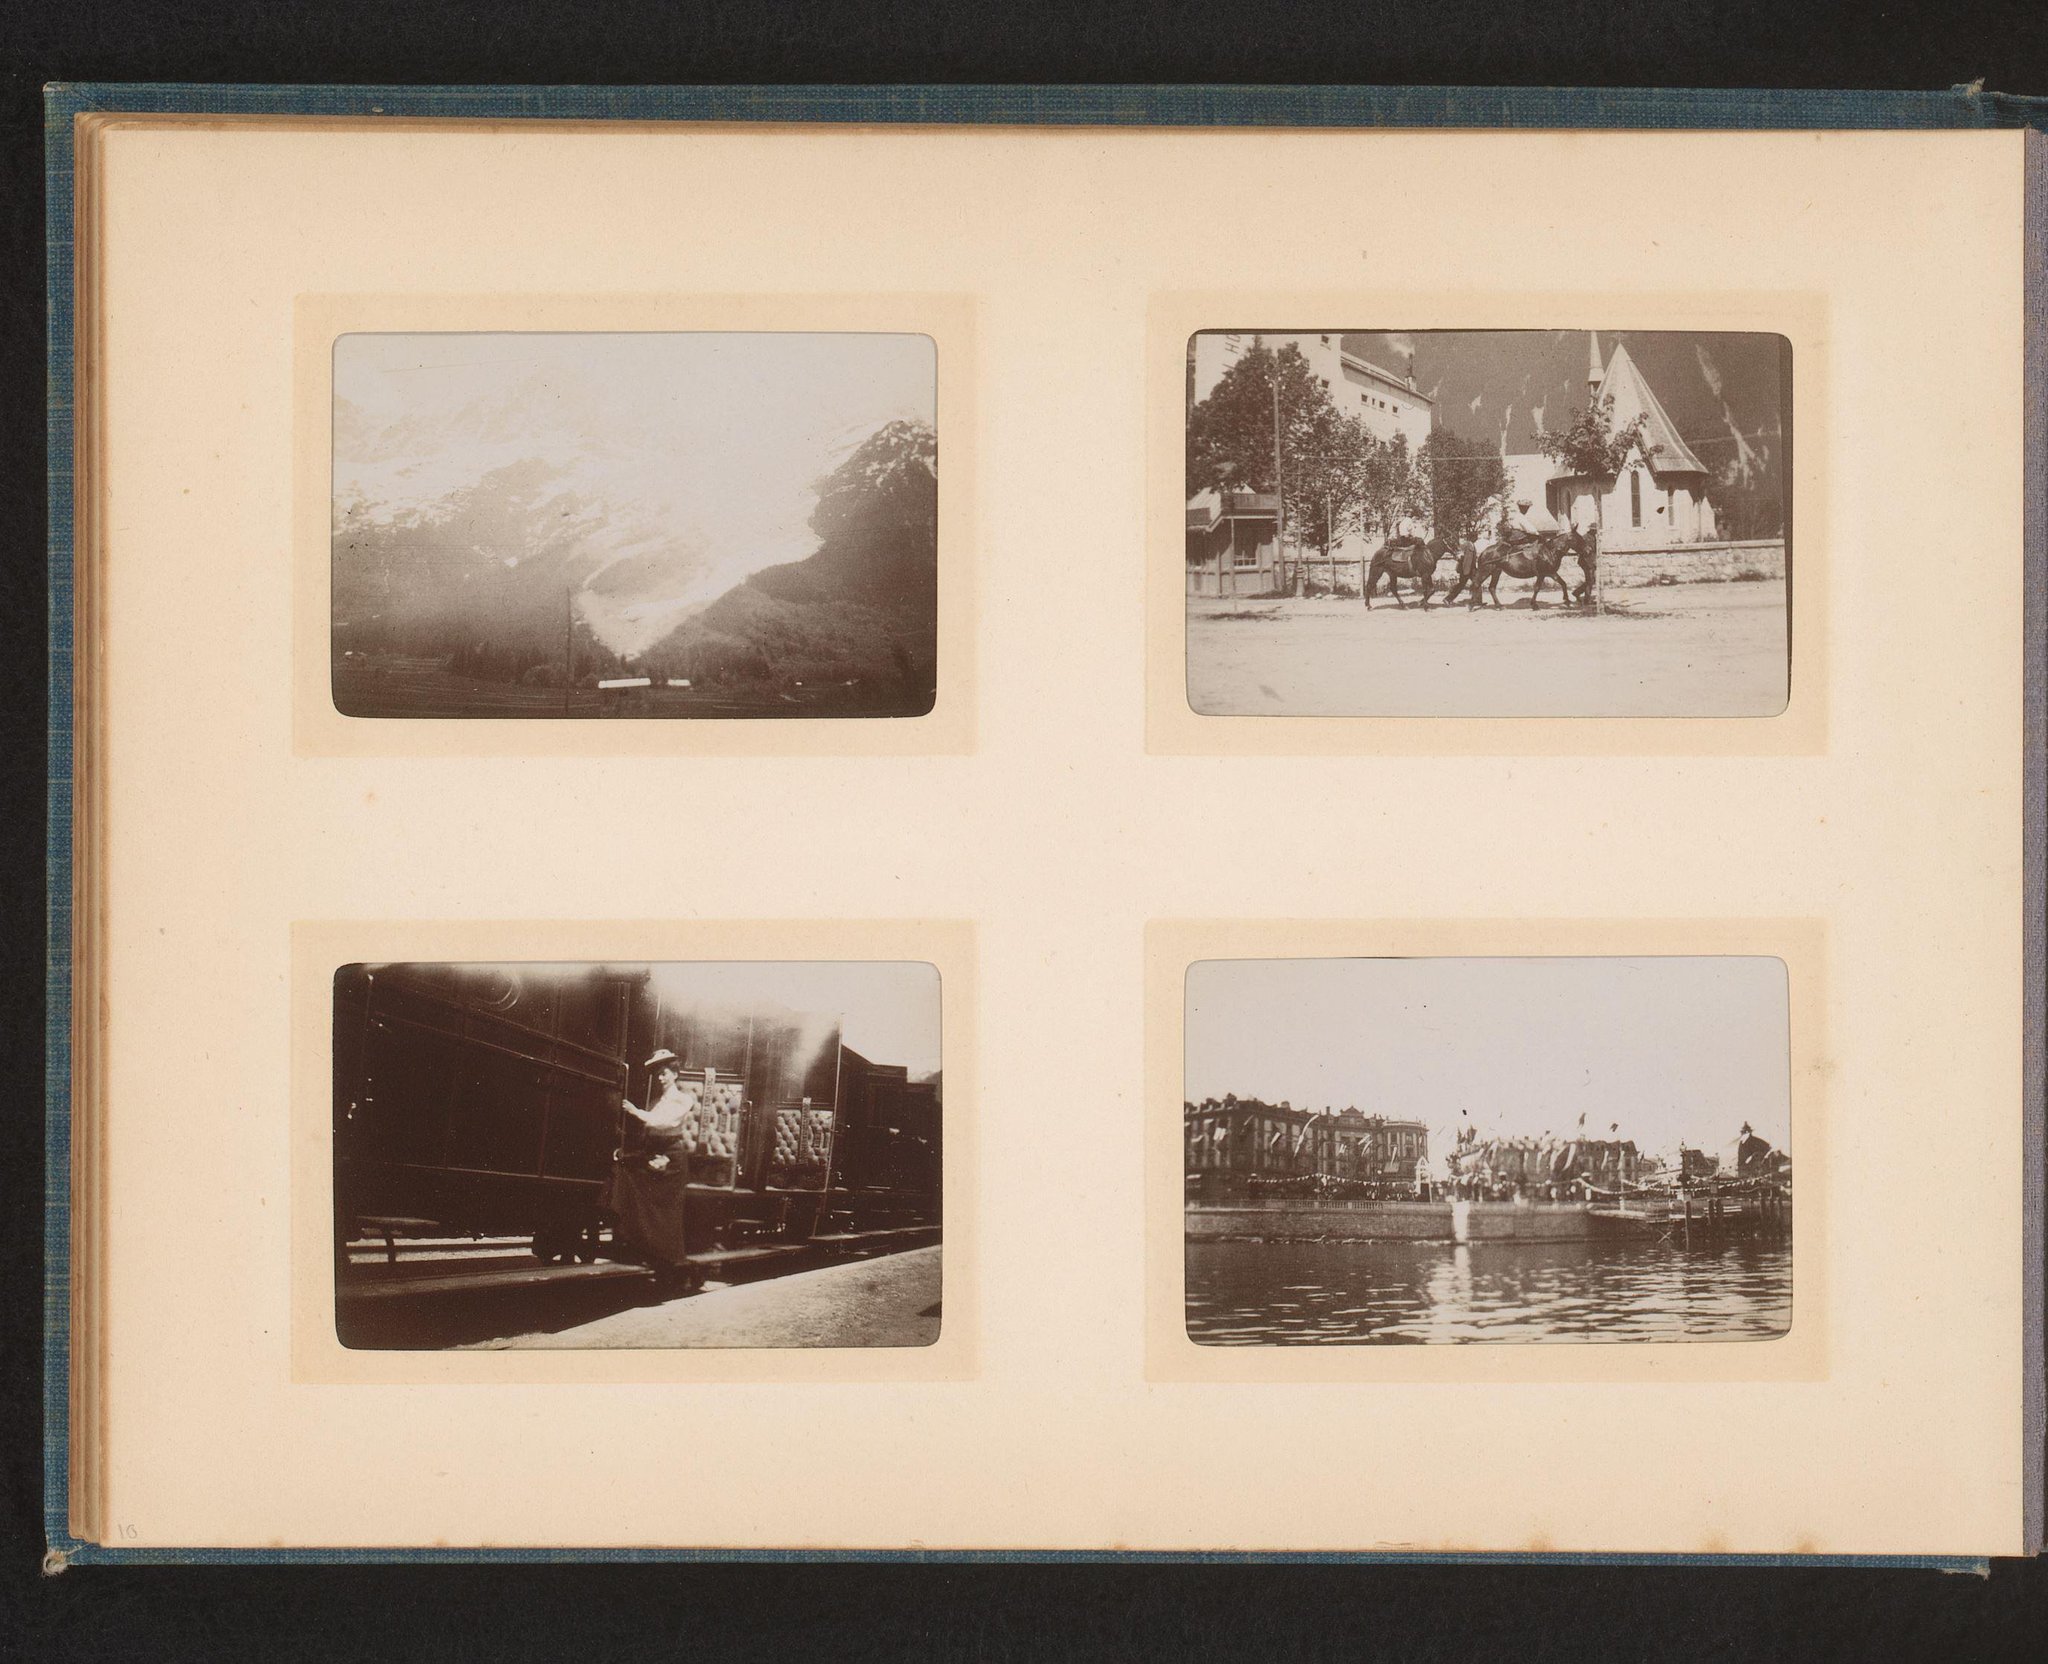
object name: album leaf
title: Dorpsgezicht, Landschap met water, Berglandschap te Frankrijk en Vrouw bij een trein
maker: Anonymous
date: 1900-1915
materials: paper, photographic support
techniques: gelatin silver print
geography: france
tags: adult man, landscapes with waters, waterscapes, seascapes (in the temperate zone), village, travelling; tourism, mountains, france